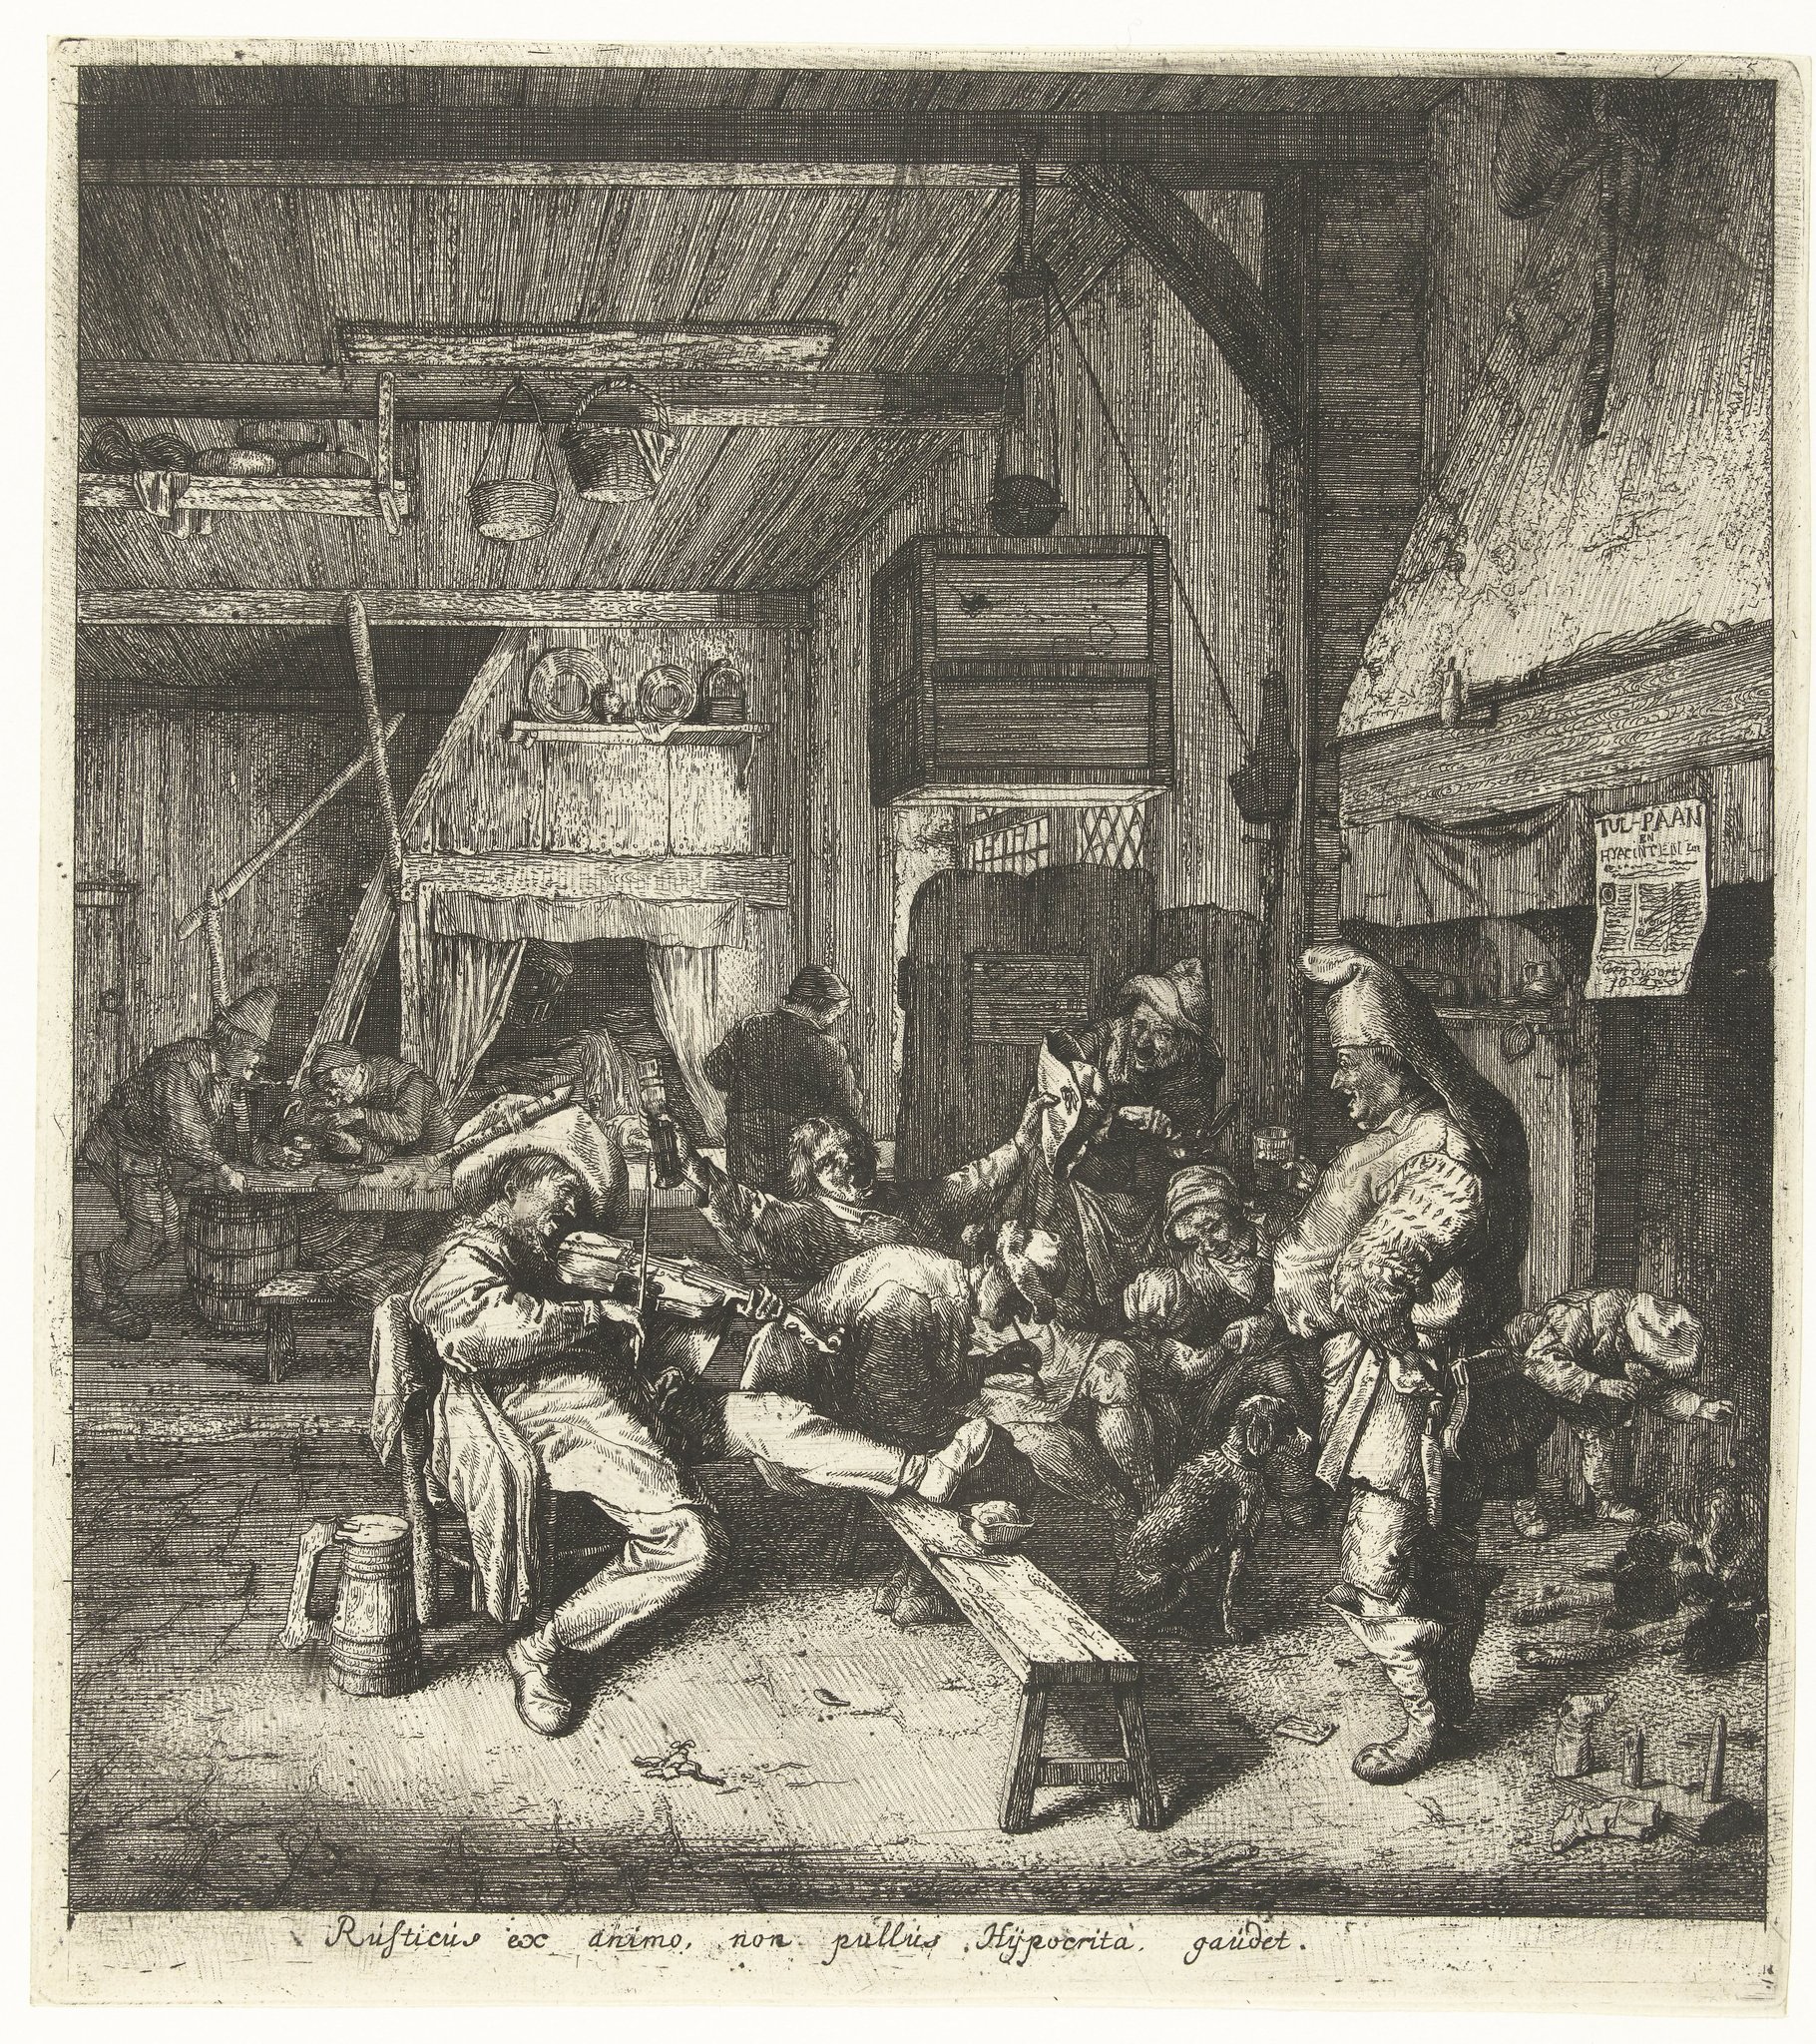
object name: print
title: Vioolspeler in de herberg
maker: cornelis dusart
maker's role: draughtsman, painter, print maker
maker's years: 1660-1704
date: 1685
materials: paper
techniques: etching, roulette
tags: one person playing string instrument (bowed), inn, coffee-house, public house, etc., pipe ~ tobacco, drinking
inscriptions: collector's mark: Lugt 240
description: Een vioolspeler vermaakt een gezelschap van rokende en drinkende mannen en een vrouw met twee kinderen in een herberg. Onder de voorstelling staat een Latijns opschrift: Rusticus ex animo non pullus Hypocrita gaudet